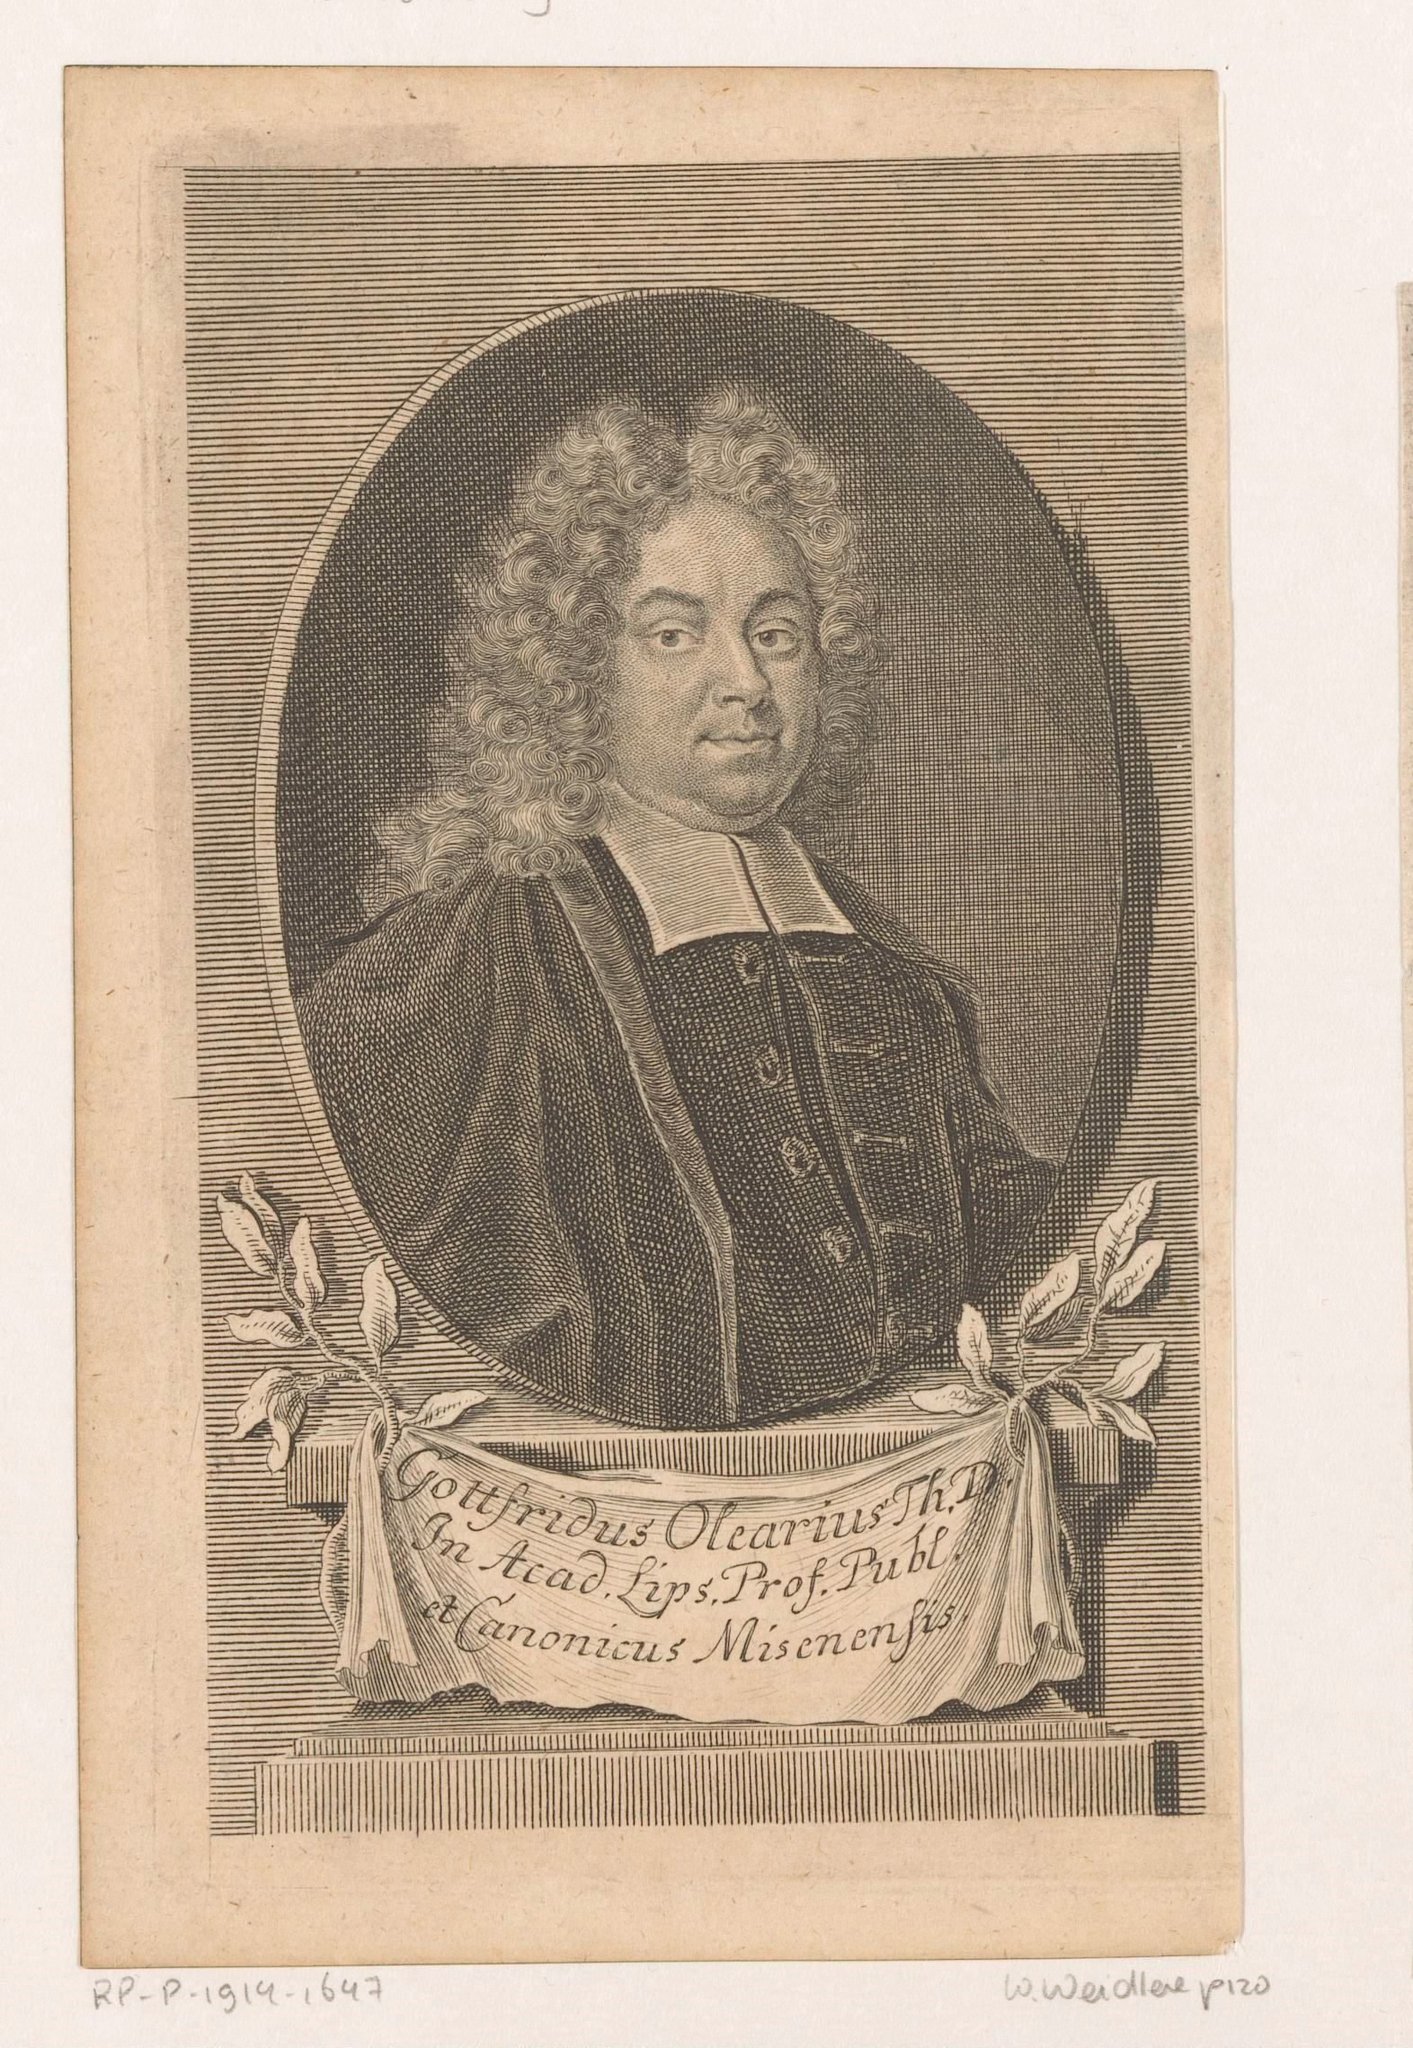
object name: print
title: Portret van Gottfried Olearius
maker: martin bernigeroth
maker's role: print maker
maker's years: 1670-1733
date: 1713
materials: paper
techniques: engraving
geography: leipzig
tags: gottfried olearius (ii), historical persons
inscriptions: collector's mark: Lugt 2228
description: Prent ook gebruikt in: Deutsche Acta Eruditorum (...). dl. 17. Leipzig: Johann Gottlieb Gleditsch, 1713.